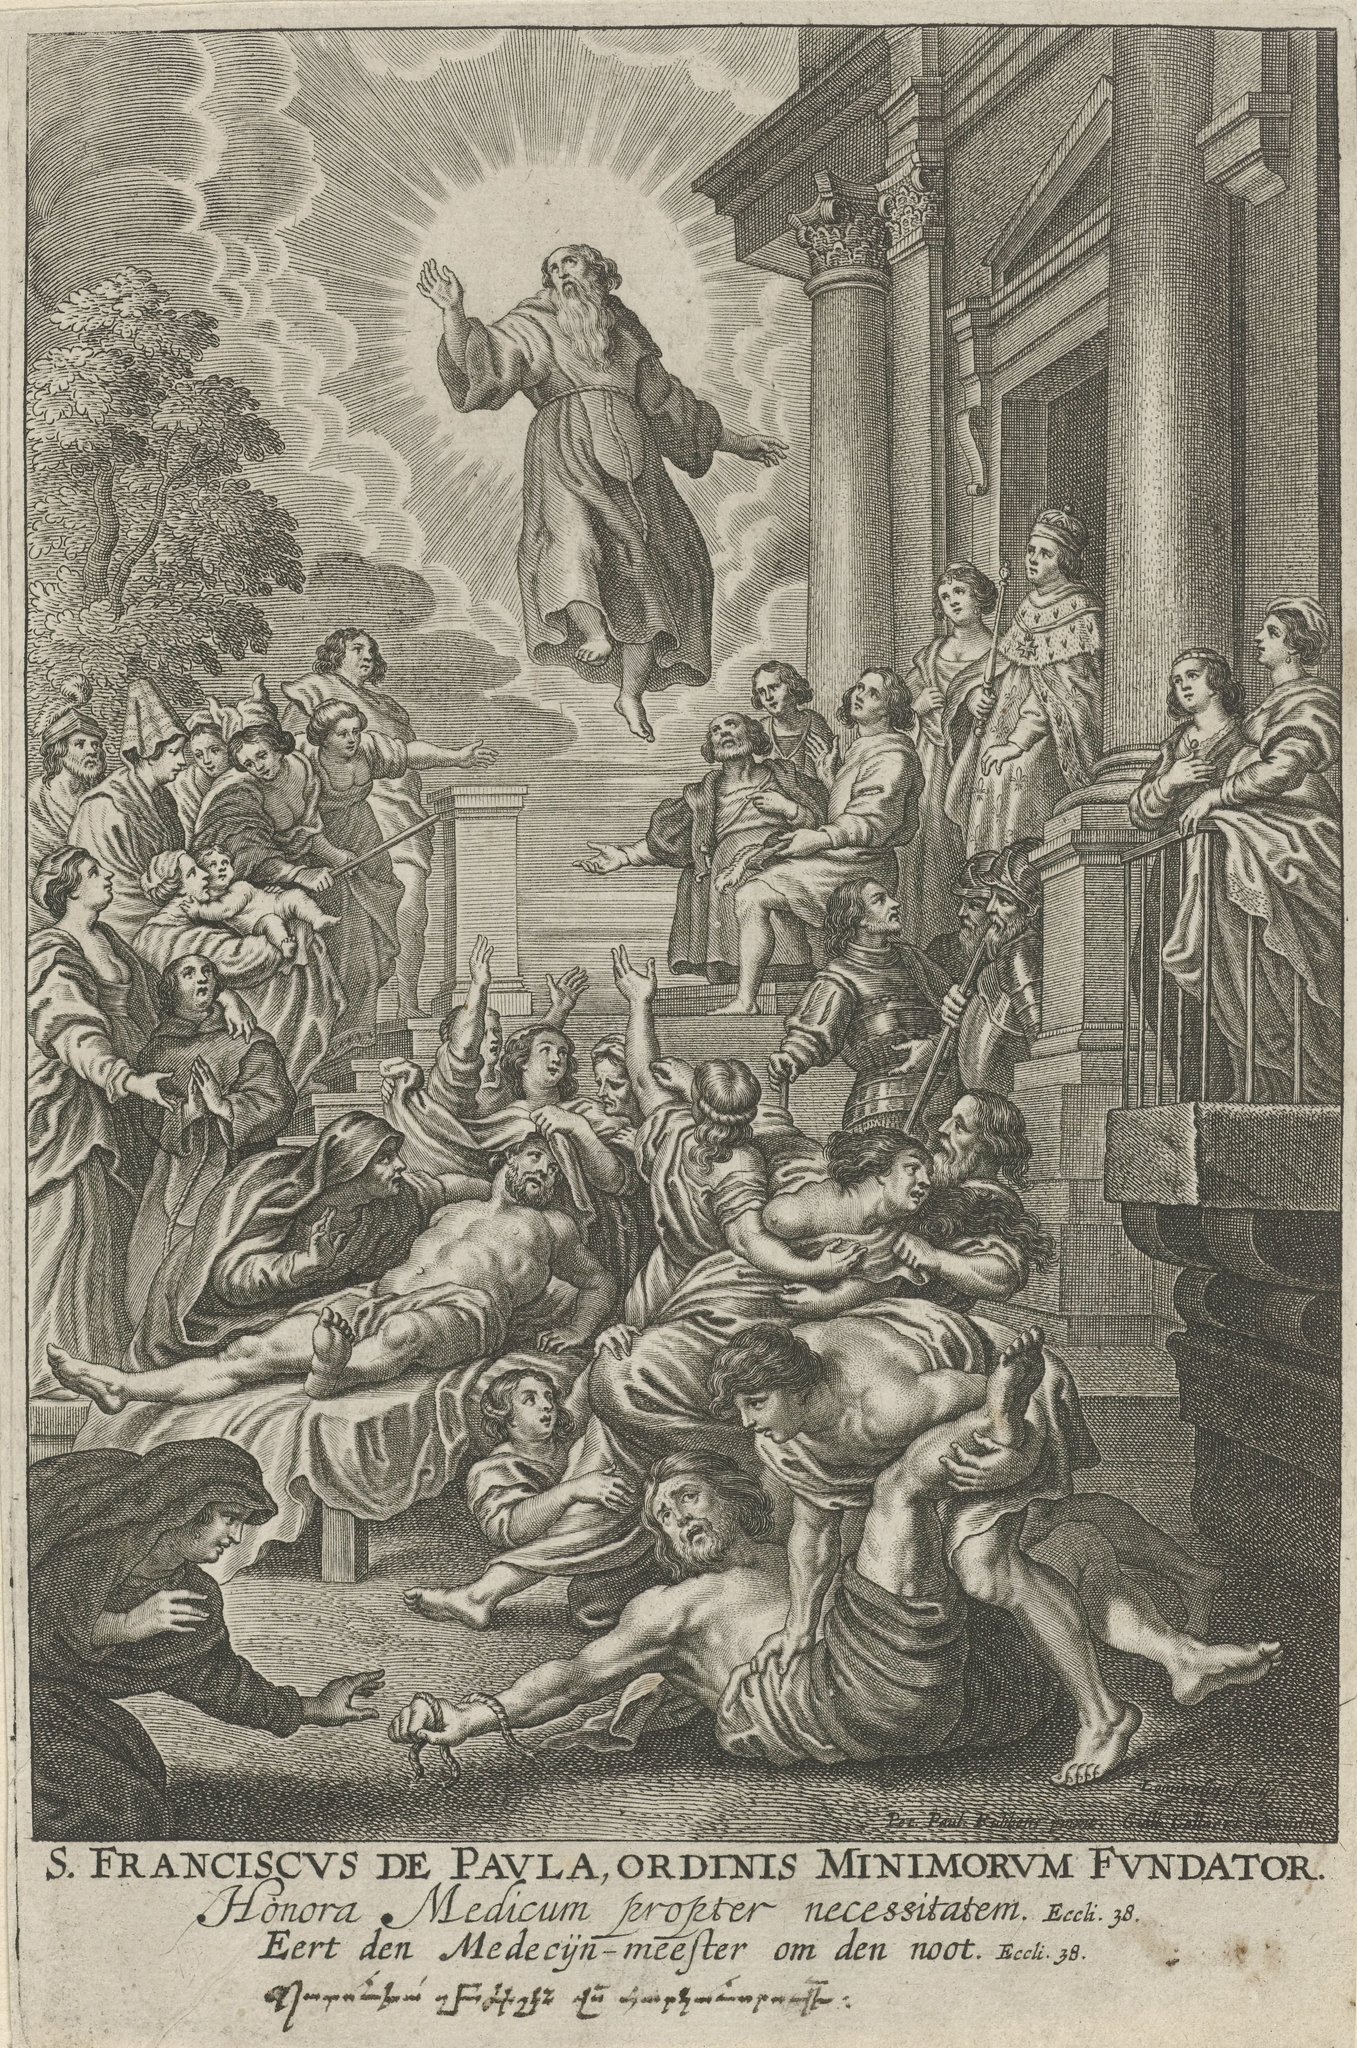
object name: print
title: S. Franciscus de Paula, Ordinis Minimorum Fundator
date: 1630-1651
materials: paper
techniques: engraving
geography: antwerp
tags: the hermit and founder of the (franciscan) minim friars, francis of paola; possible attributes: inscription 'charitas' on breast, discipline, skull, staff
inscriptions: collector's mark: Lugt 240, inscription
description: De heilige Franciscus van Paola, stichter van de Orde der Miniemen, is aan een groep mensen verschenen om de zieken onder hen te genezen. Rechts kijken een koning en koningin vanaf een bordes toe. In de marge een drieregelig onderschrift in Latijn en Nederlands.